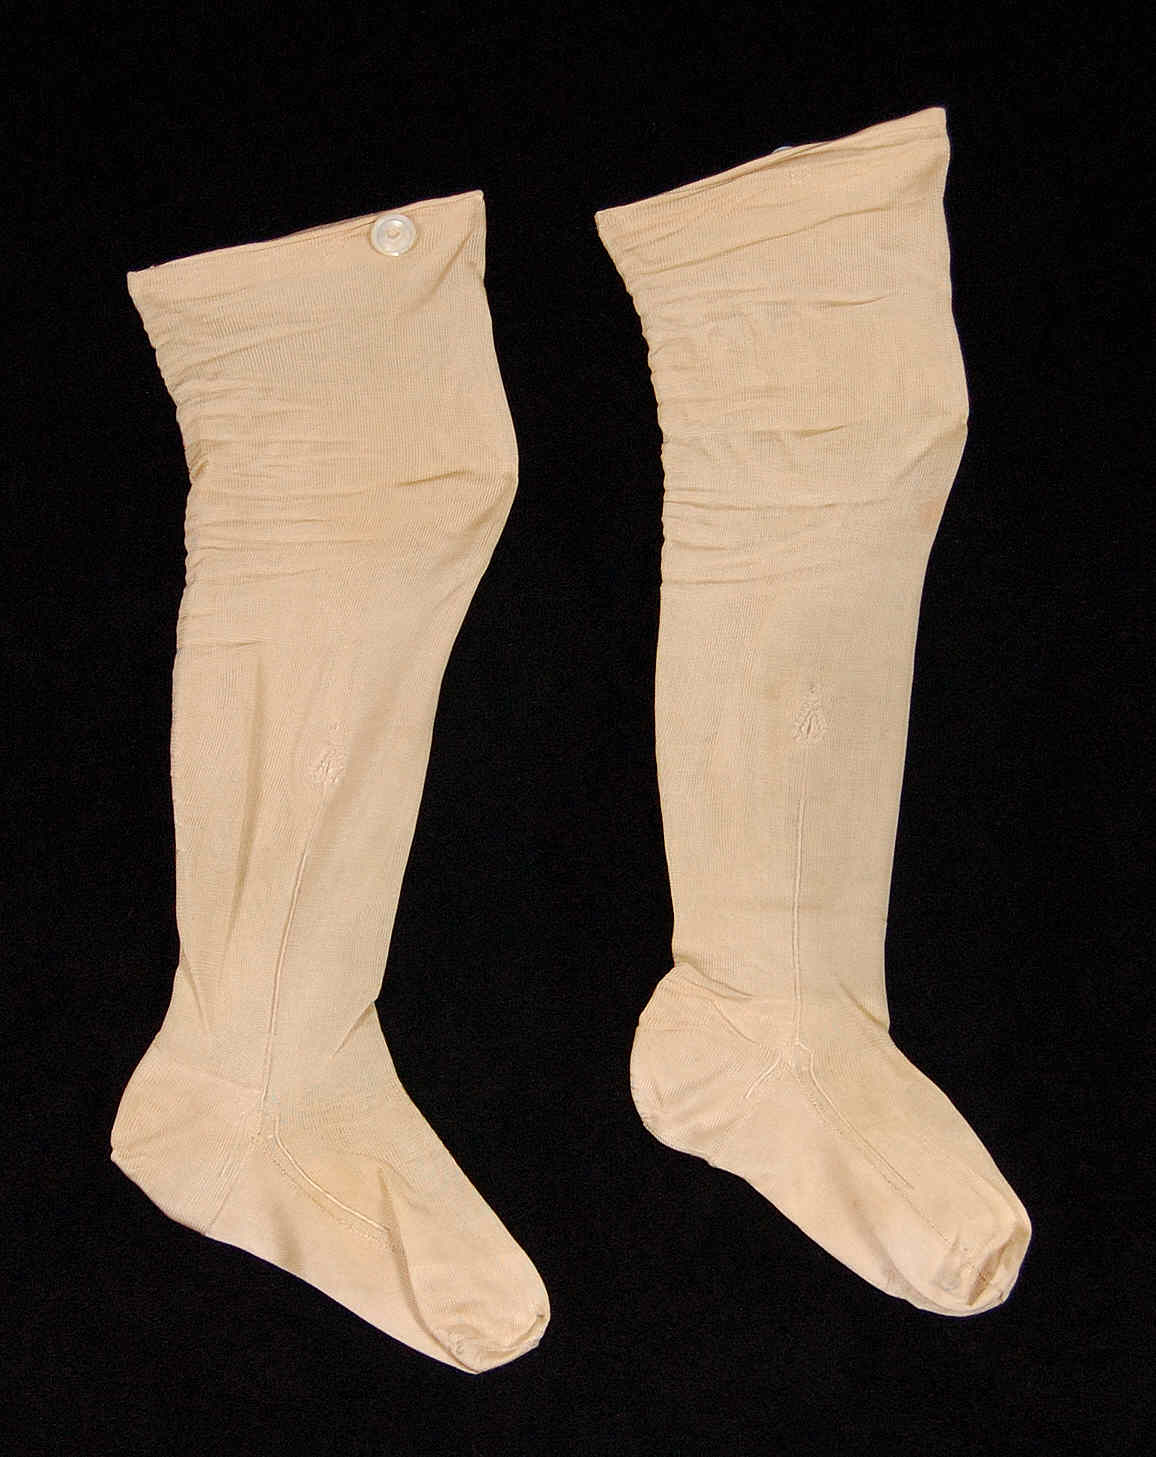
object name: stocking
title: Stockings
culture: american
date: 1851-1875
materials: silk